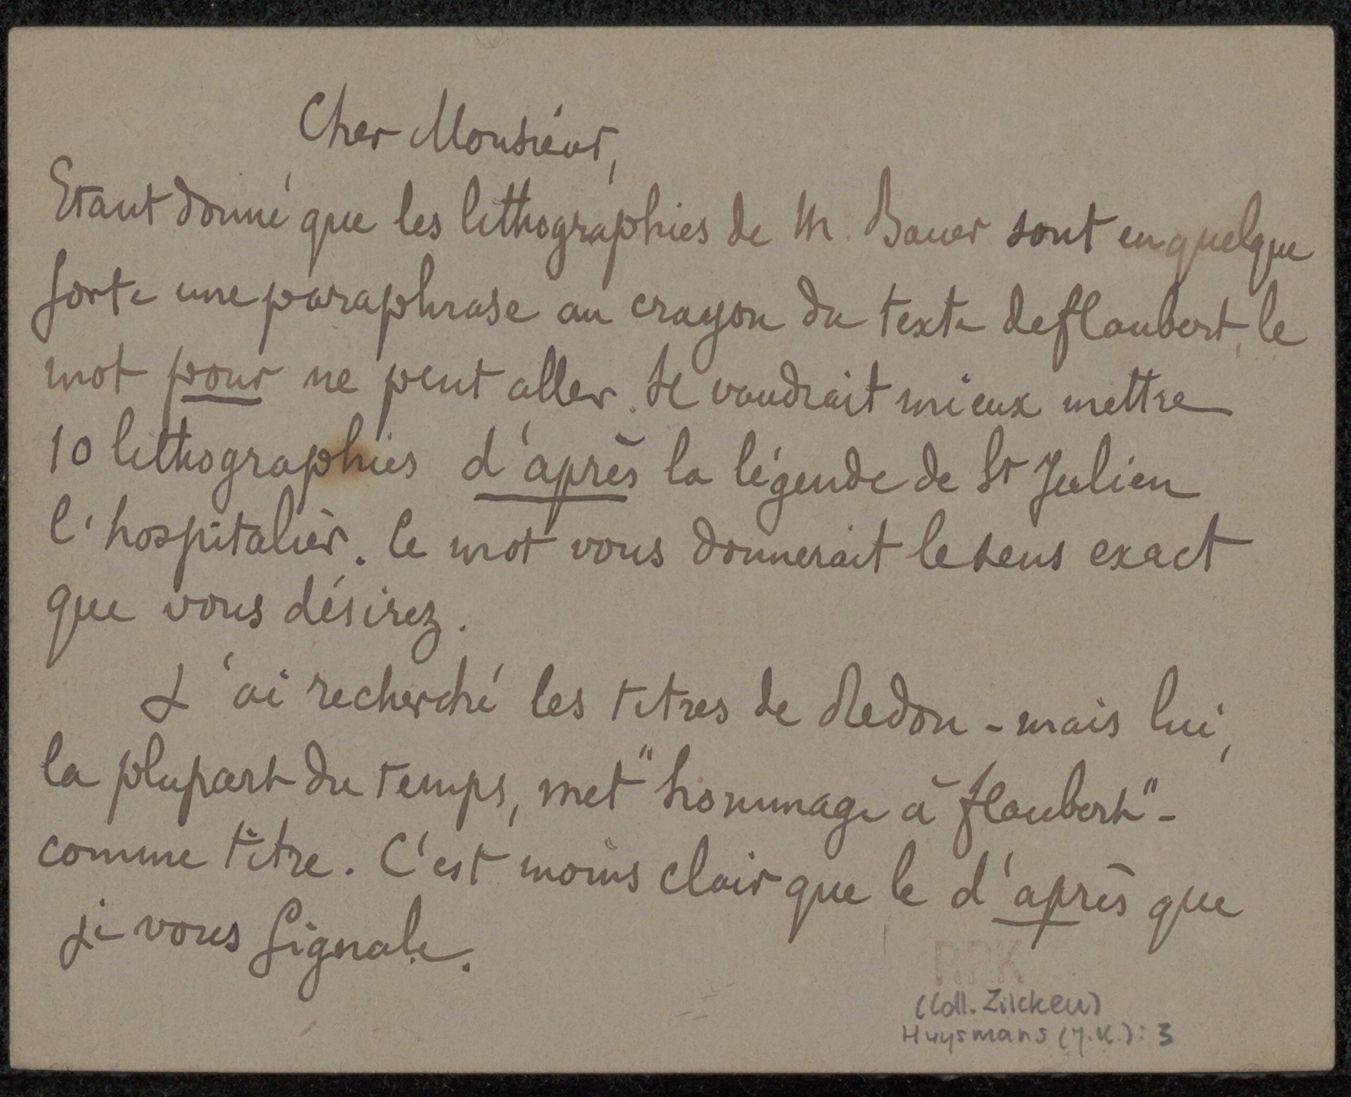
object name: letter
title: Brief aan Philip Zilcken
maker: joris-karl huysmans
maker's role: schrijver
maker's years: 1848-1907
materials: cardboard, ink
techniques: pen, writing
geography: paris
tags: amsterdam, print maker, marius bauer, gustave flaubert, the hague, painter, draughtsman, philip zilcken, literature ~ arts, the graphic arts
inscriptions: collector's mark: ‘RPK’